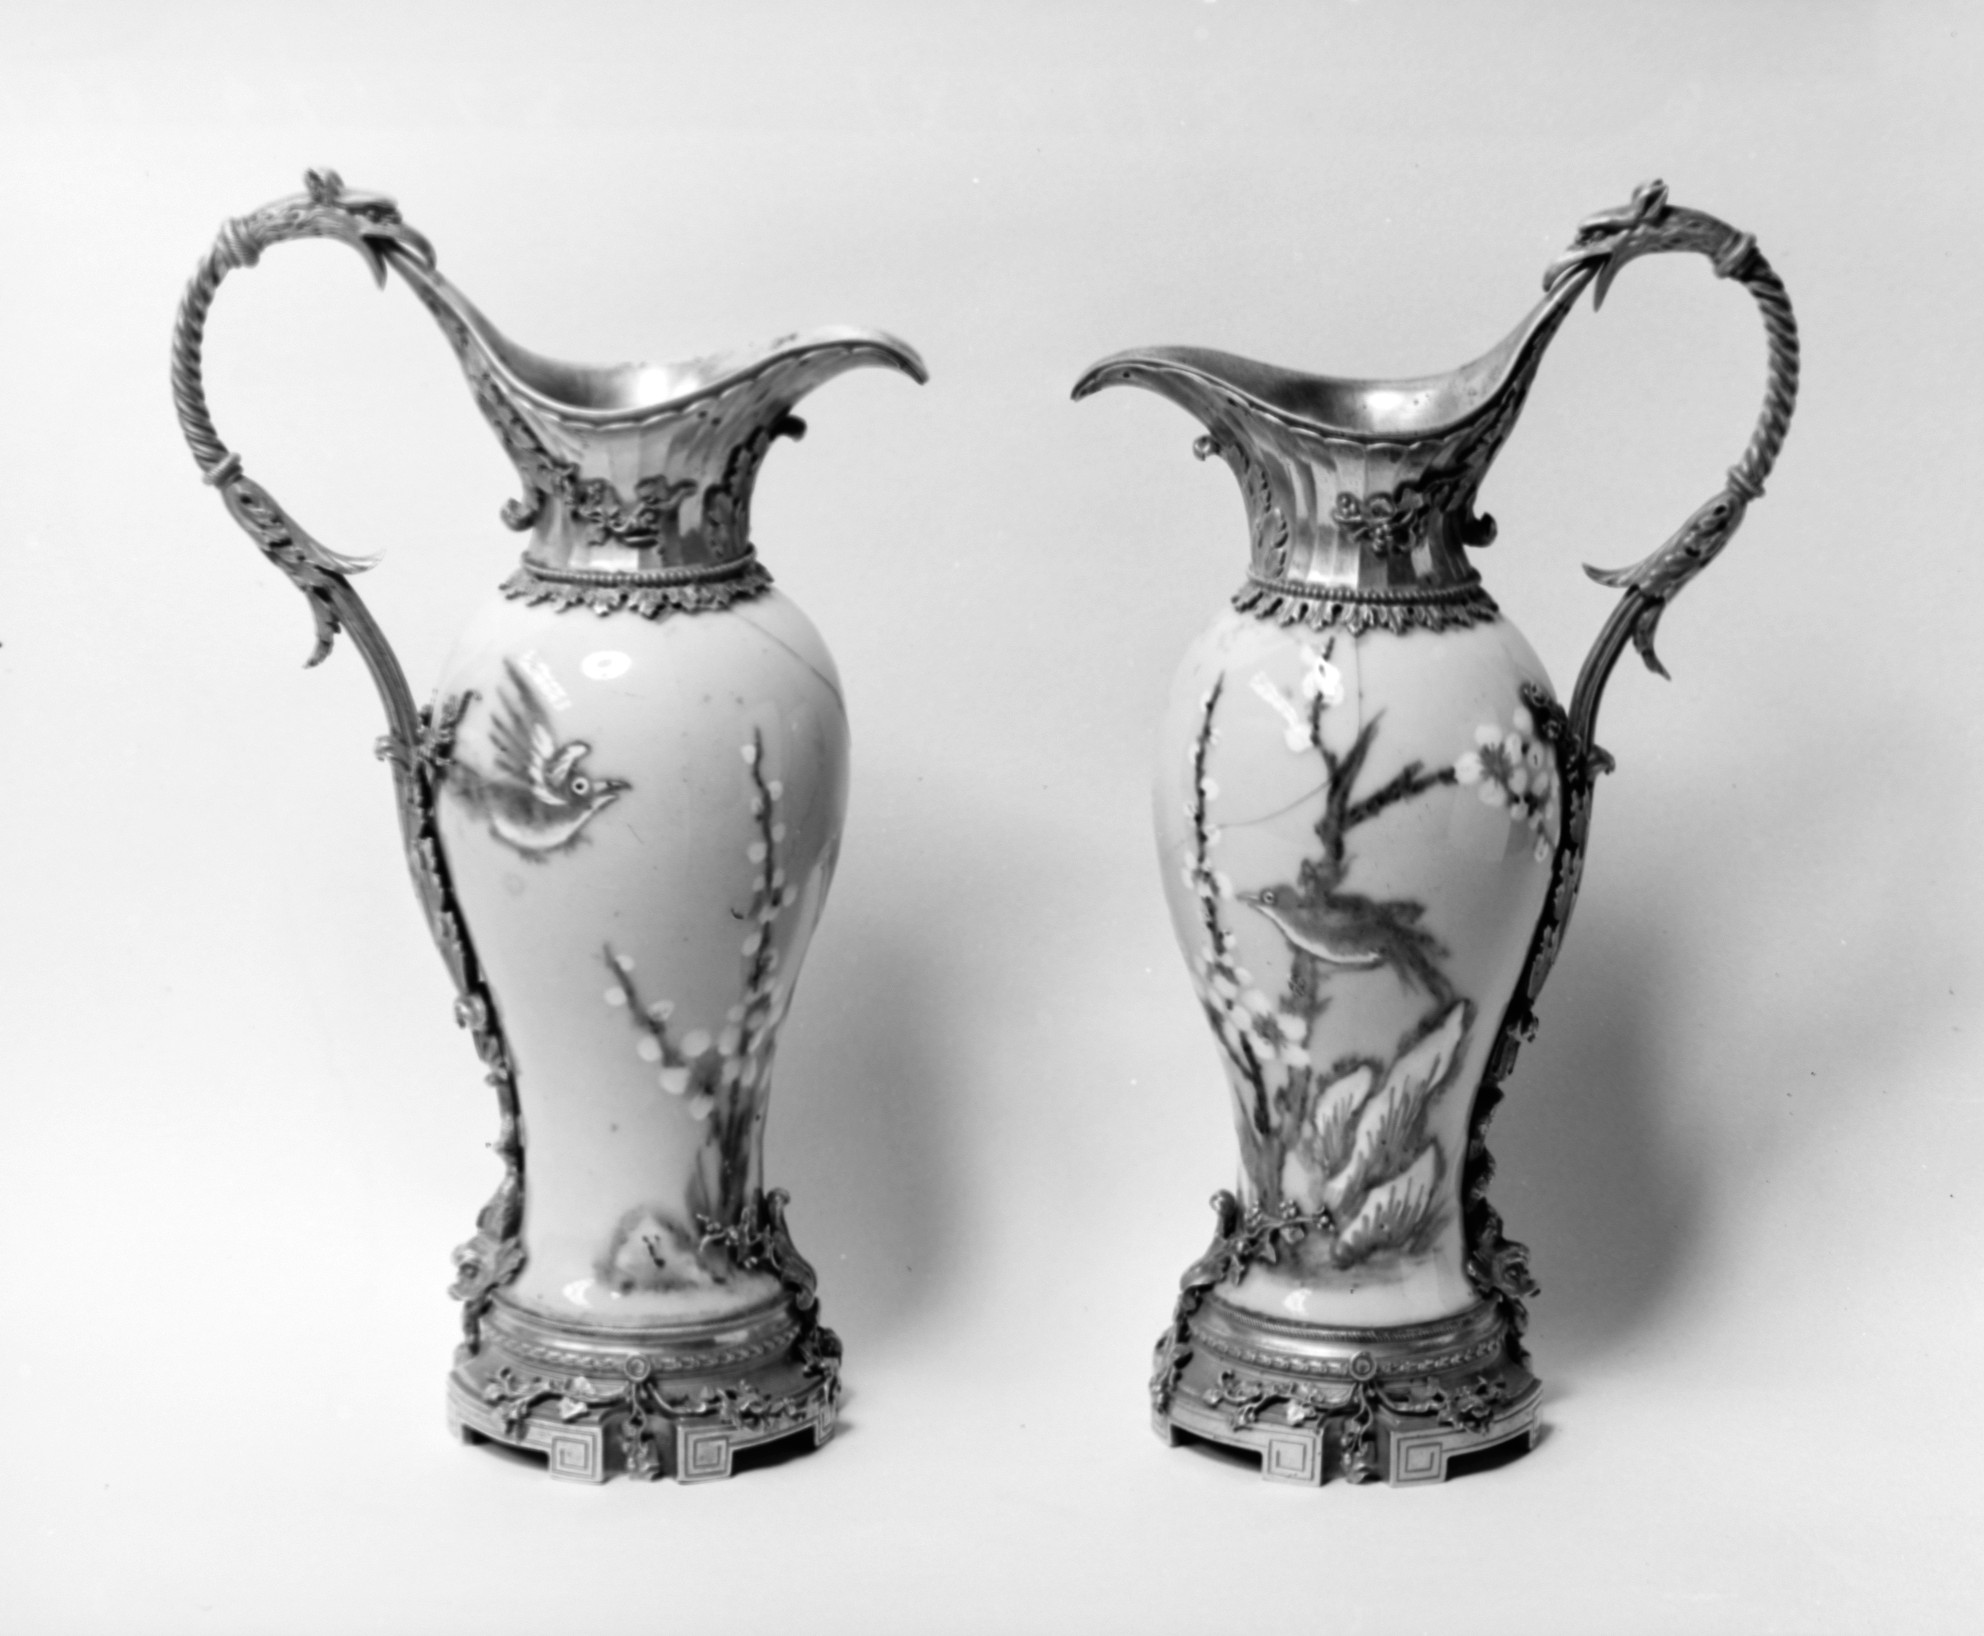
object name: ewer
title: Pair of ewers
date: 1701-1800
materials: gilt bronze, hard paste porcelain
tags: birds,flowers